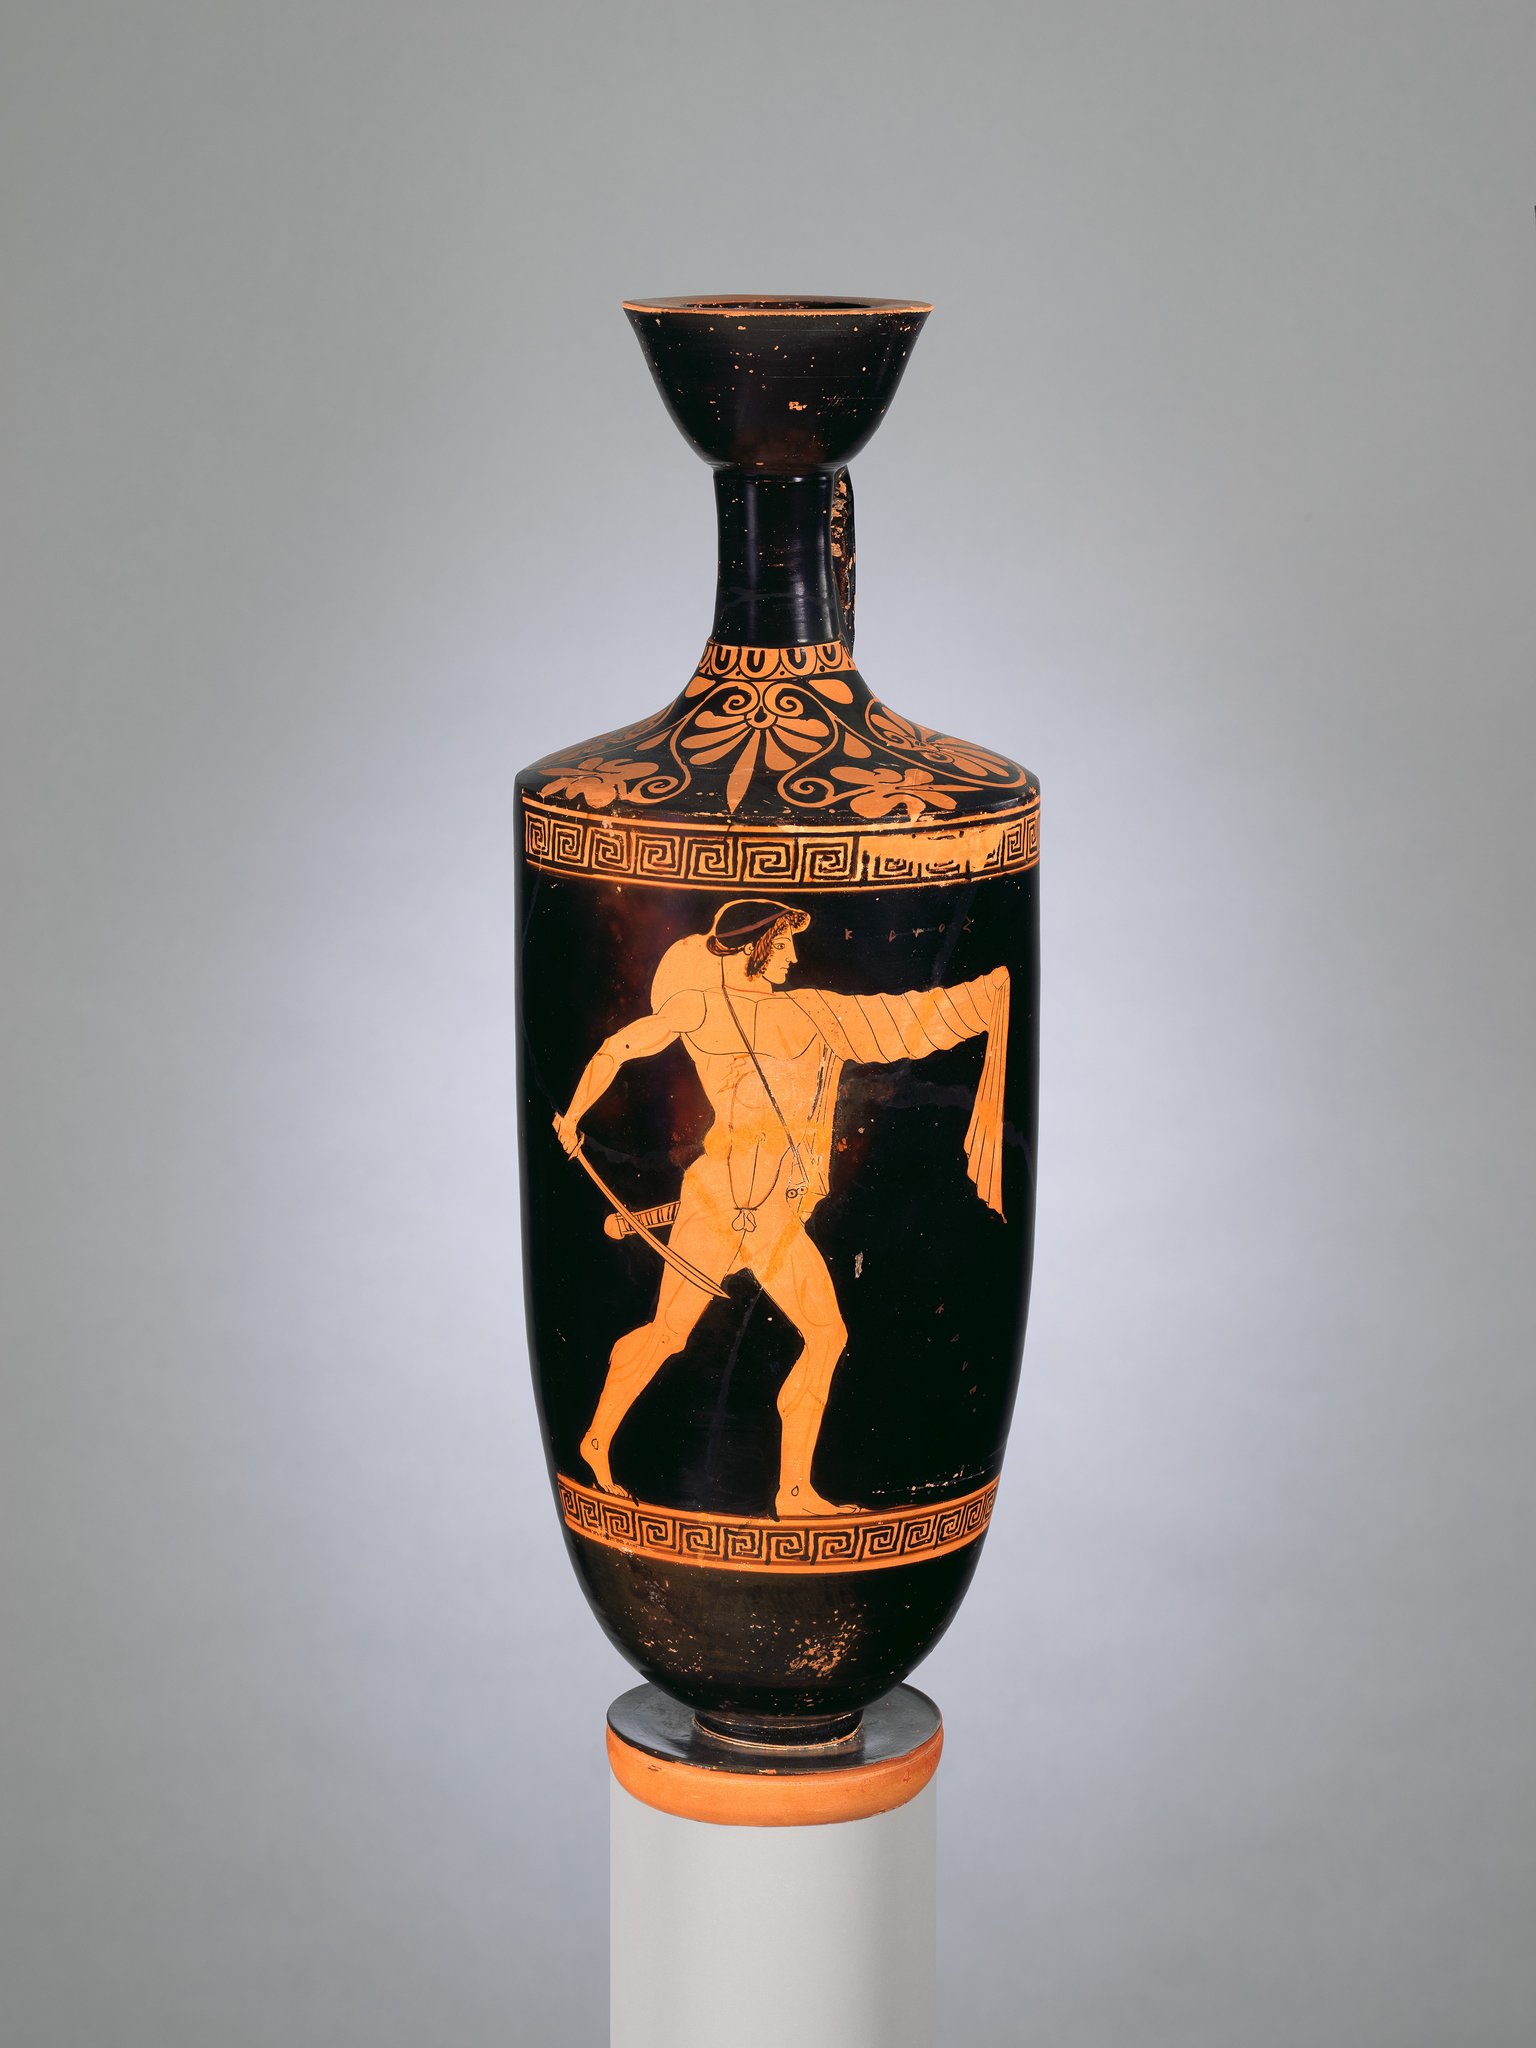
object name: lekythos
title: Terracotta lekythos (oil flask)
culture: greek, attic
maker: oionokles painter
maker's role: artist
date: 460-450 BCE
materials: terracotta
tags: male nudes